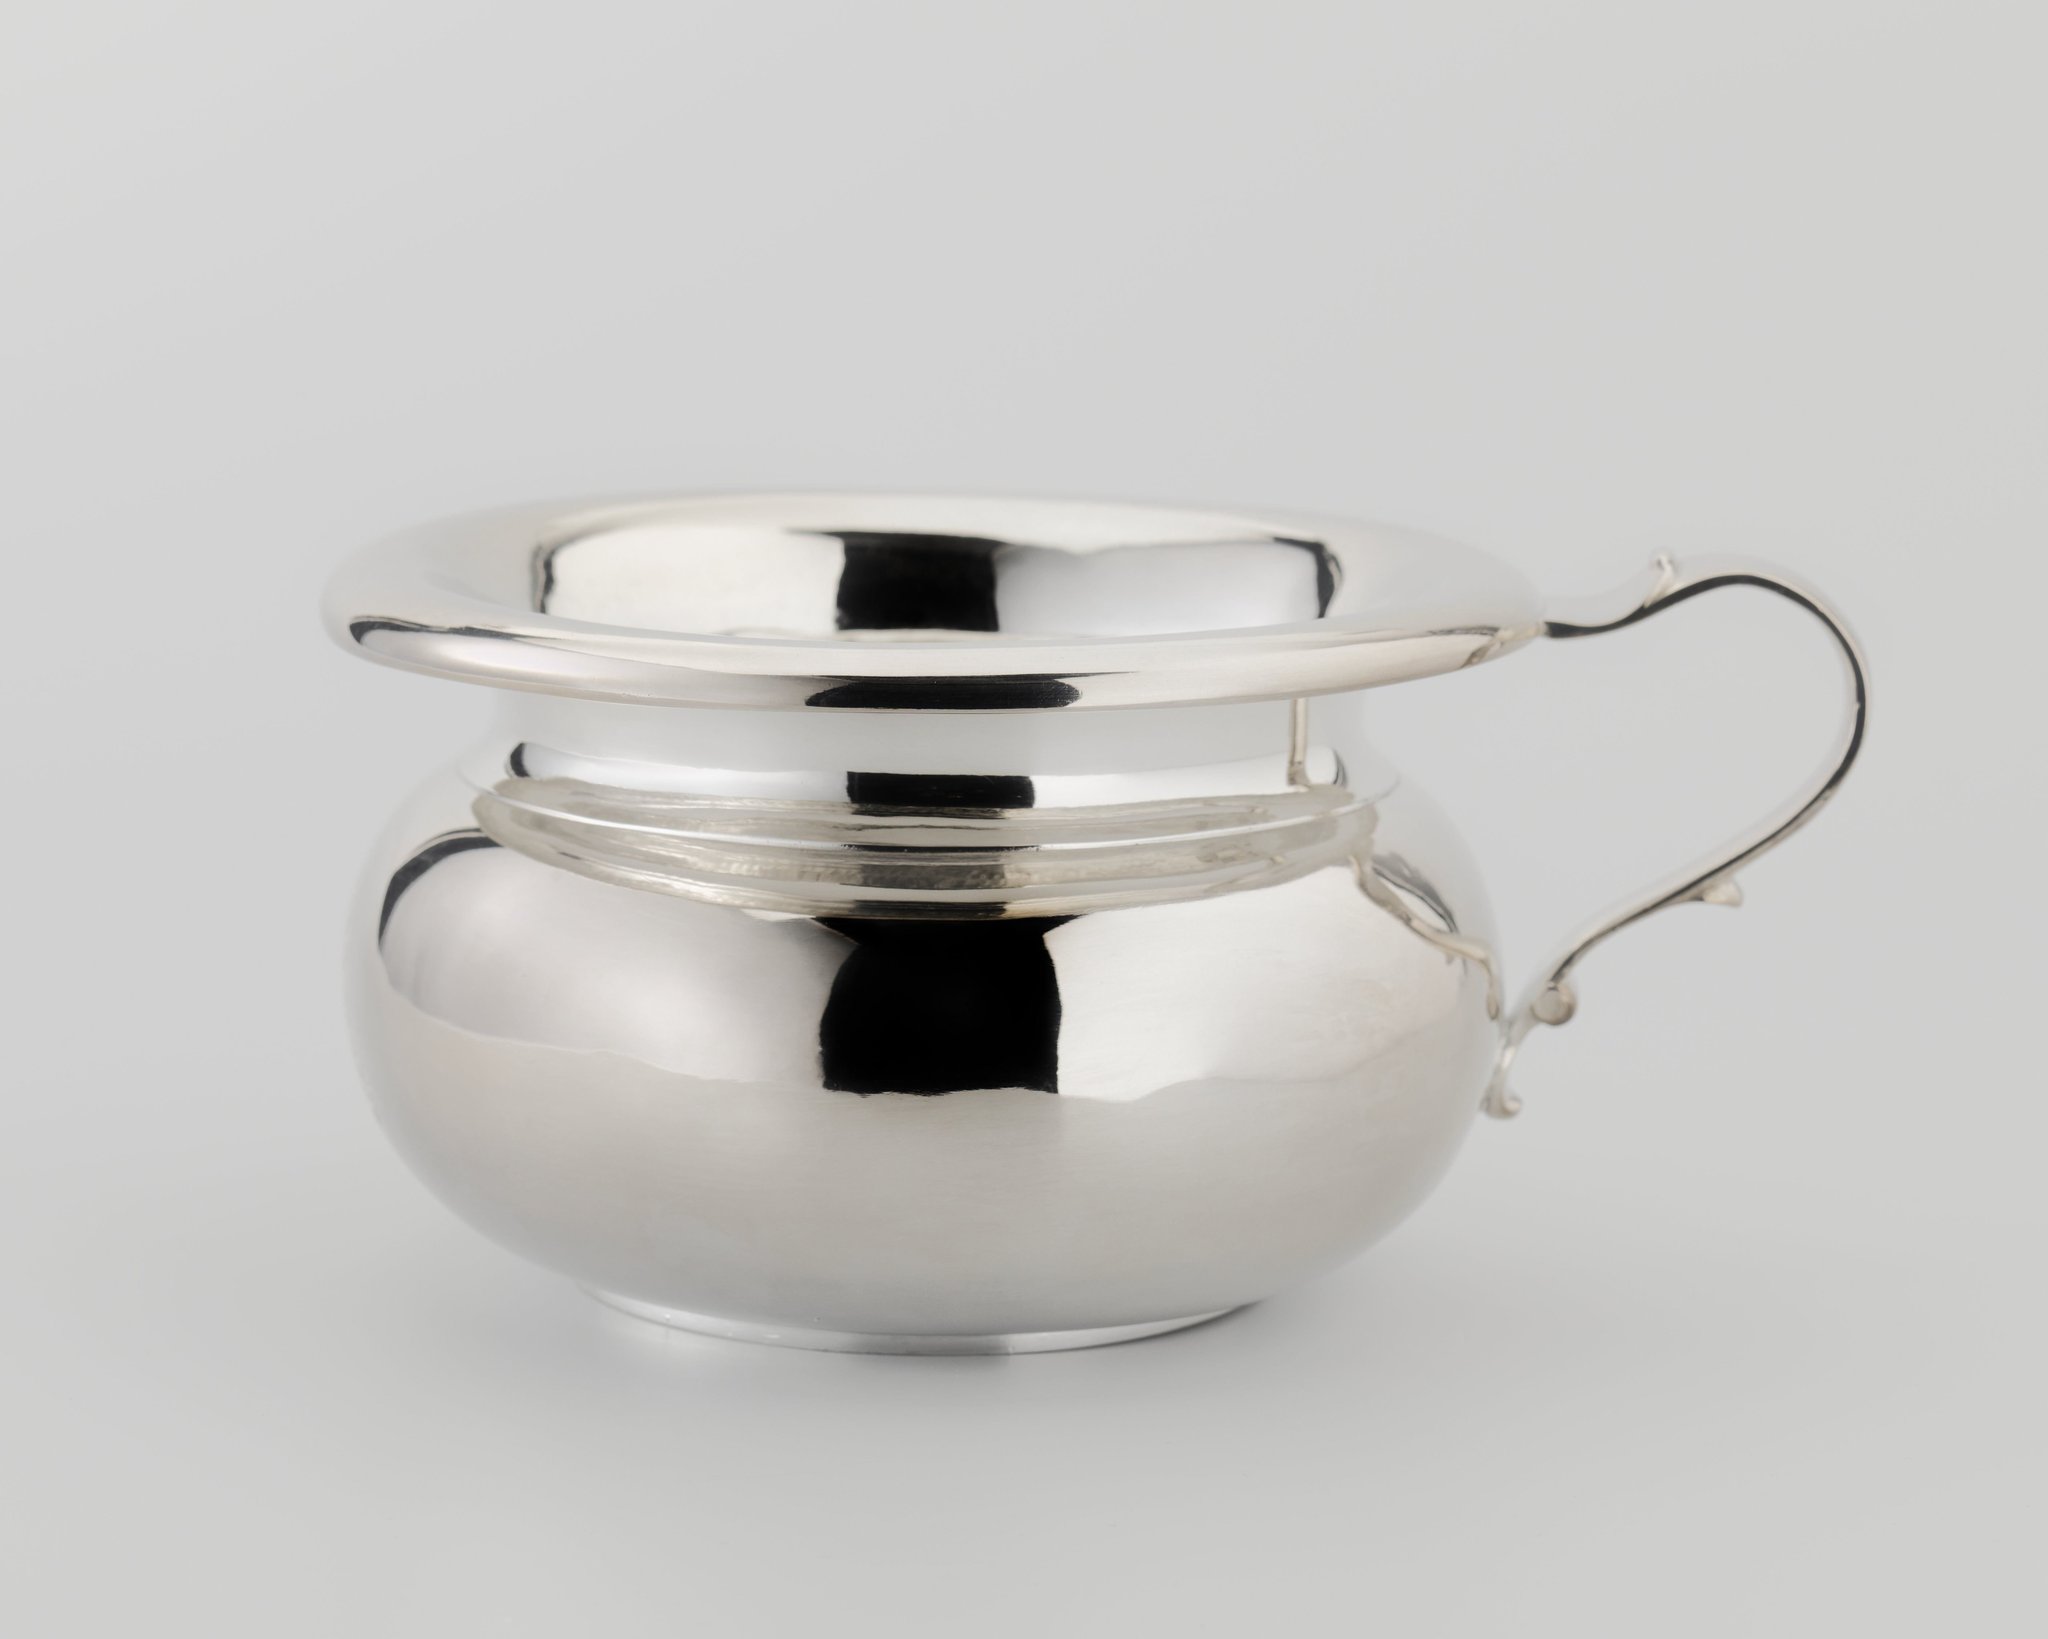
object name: chamber pot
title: Kamerpot met het alliantiewapen Torck-De Rode van Heeckeren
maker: harmanus nieuwenhuys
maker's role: silversmith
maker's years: 1711-1763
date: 1750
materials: silver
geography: amsterdam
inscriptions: town mark: ‘Amsterdam’, alloy mark: ‘Hollandse leeuw’, date letter: ‘Q’, : ‘ZI’, maker's mark: ‘HNH in rechthoek met ingezwenkte hoeken’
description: Po. Zilver. Amsterdam, 1750, toegeschreven aan Harmanus Nieuwenhuis. Geschenk Commissie voor Fotoverkoop, 1974.